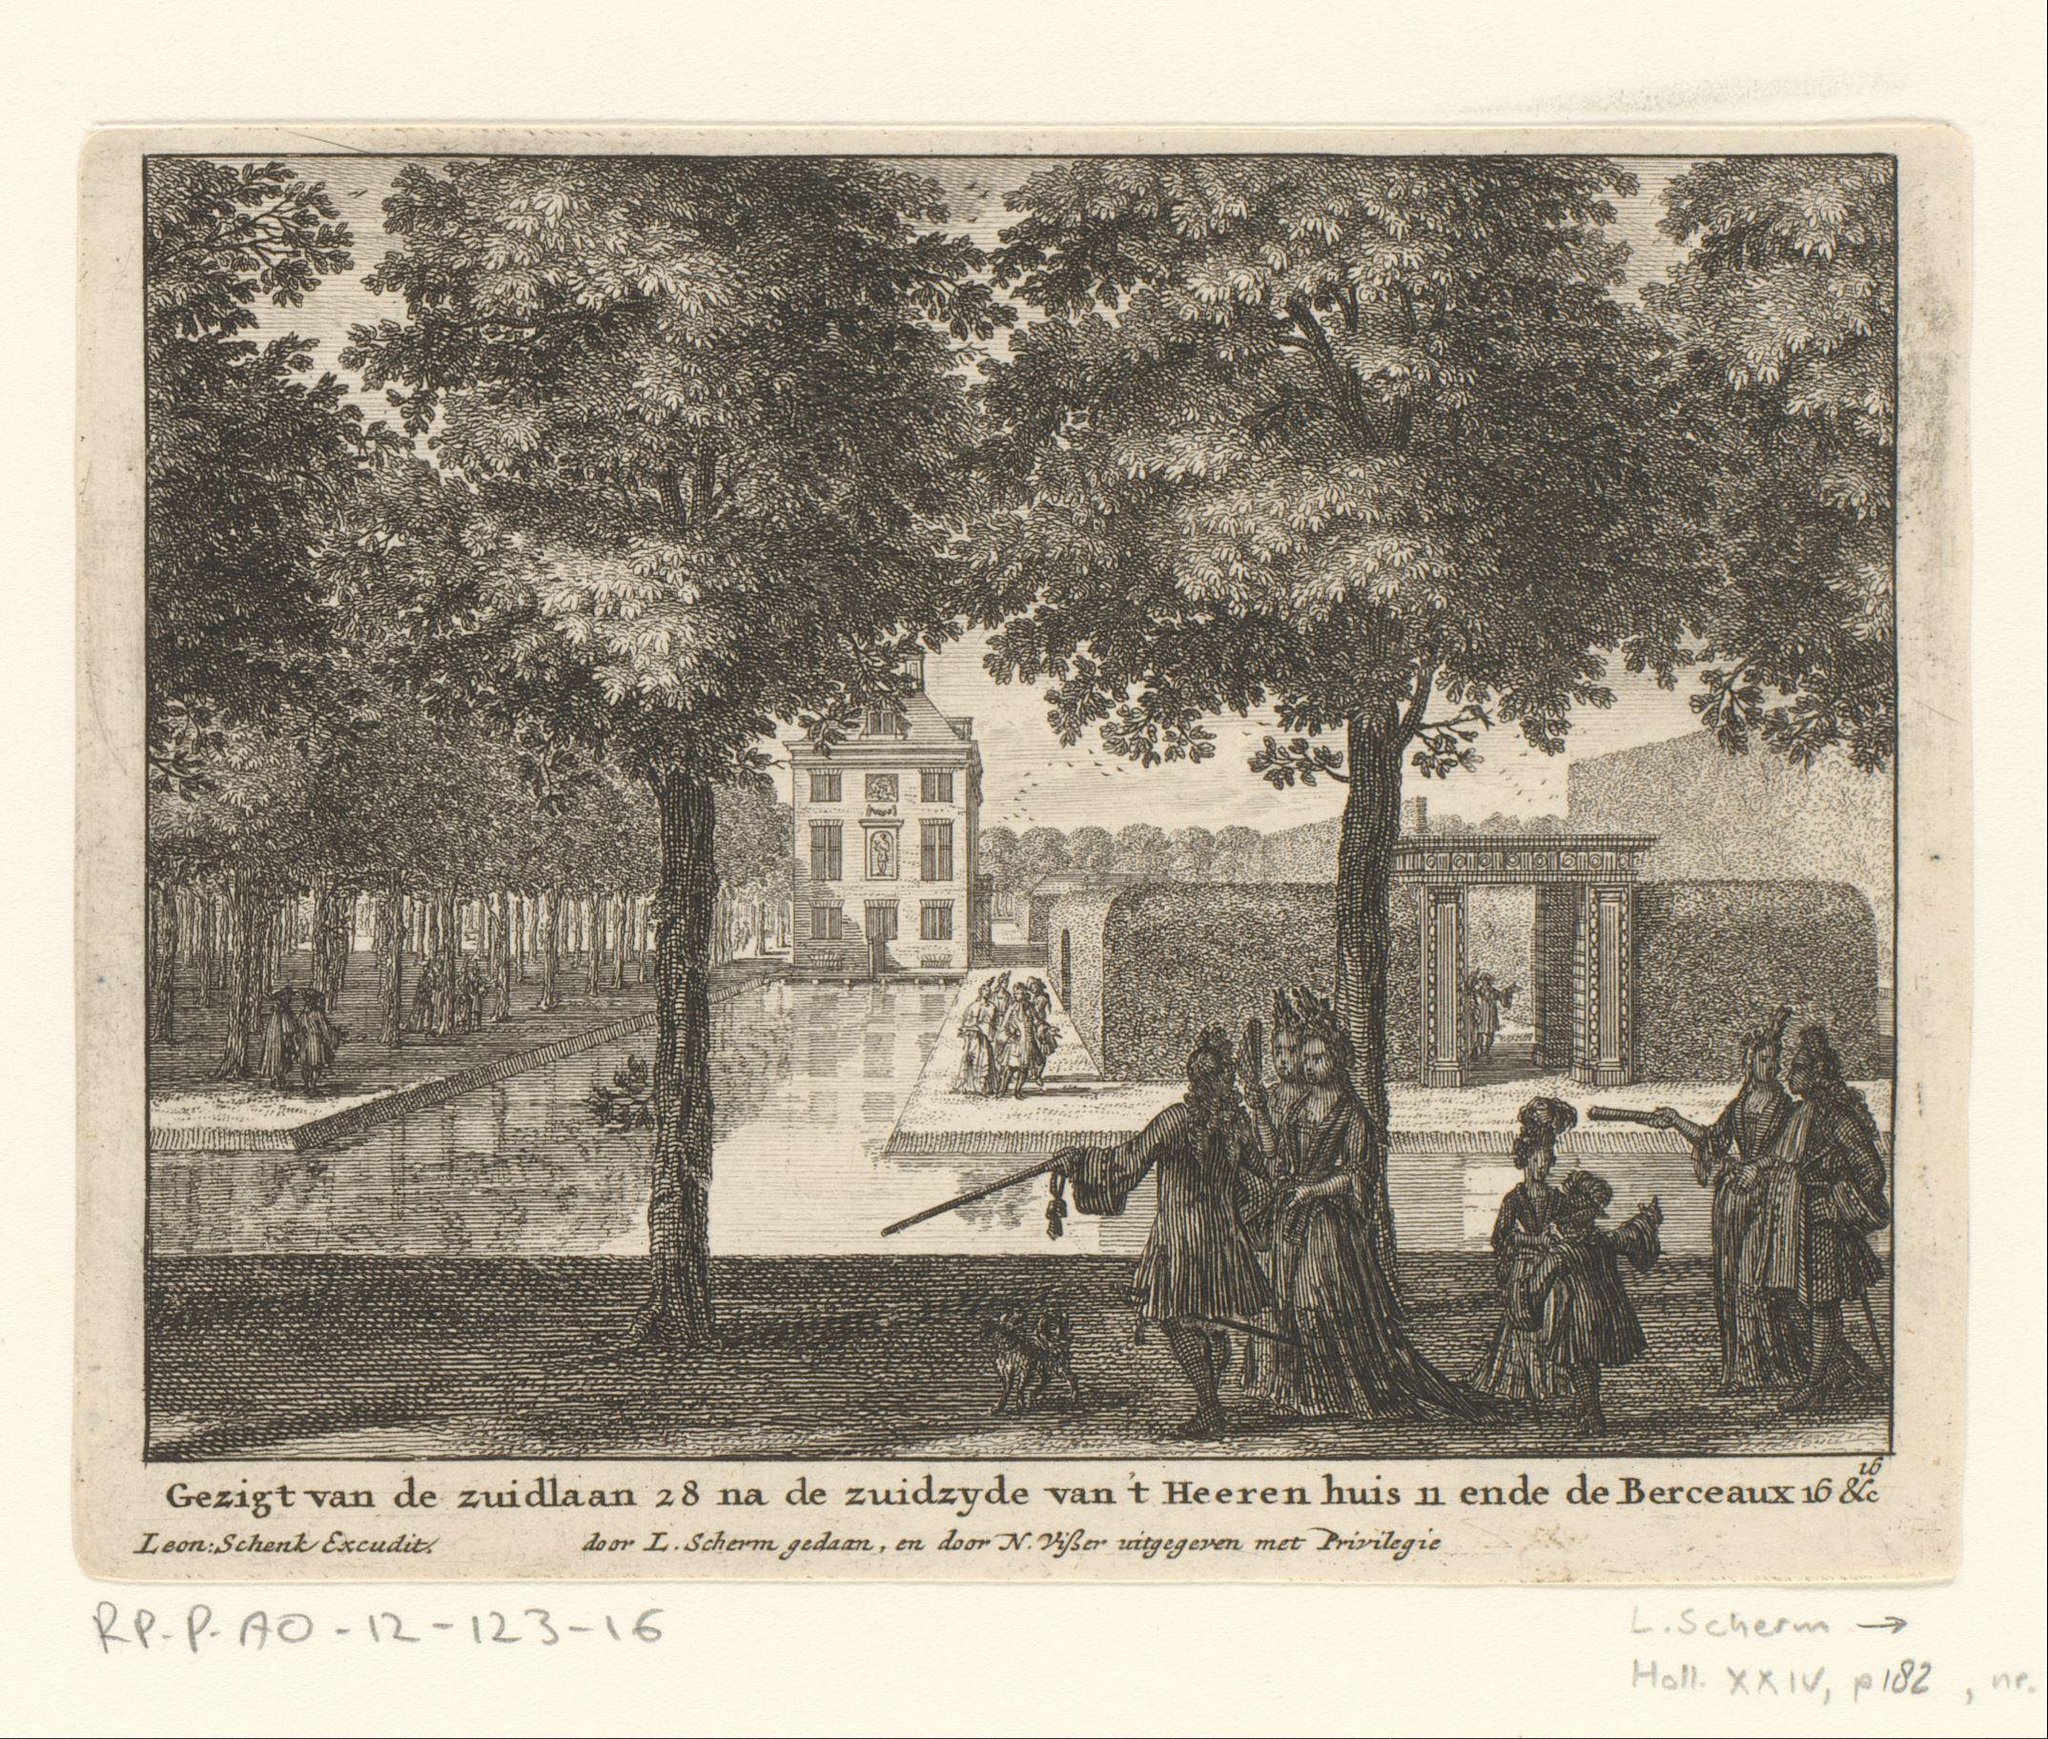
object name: print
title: Gezigt van de zuidlaan na de zuidzyde van t Heerenhuis ende de Berceaux &c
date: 1689-1701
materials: paper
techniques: etching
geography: amsterdam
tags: french or architectonic garden; formal garden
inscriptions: collector's mark: Lugt 2228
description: Tuin met een gracht aan de zuidzijde van Huis Clingendael te Den Haag. Onder de bomen elegant geklede wandelende dames en heren.